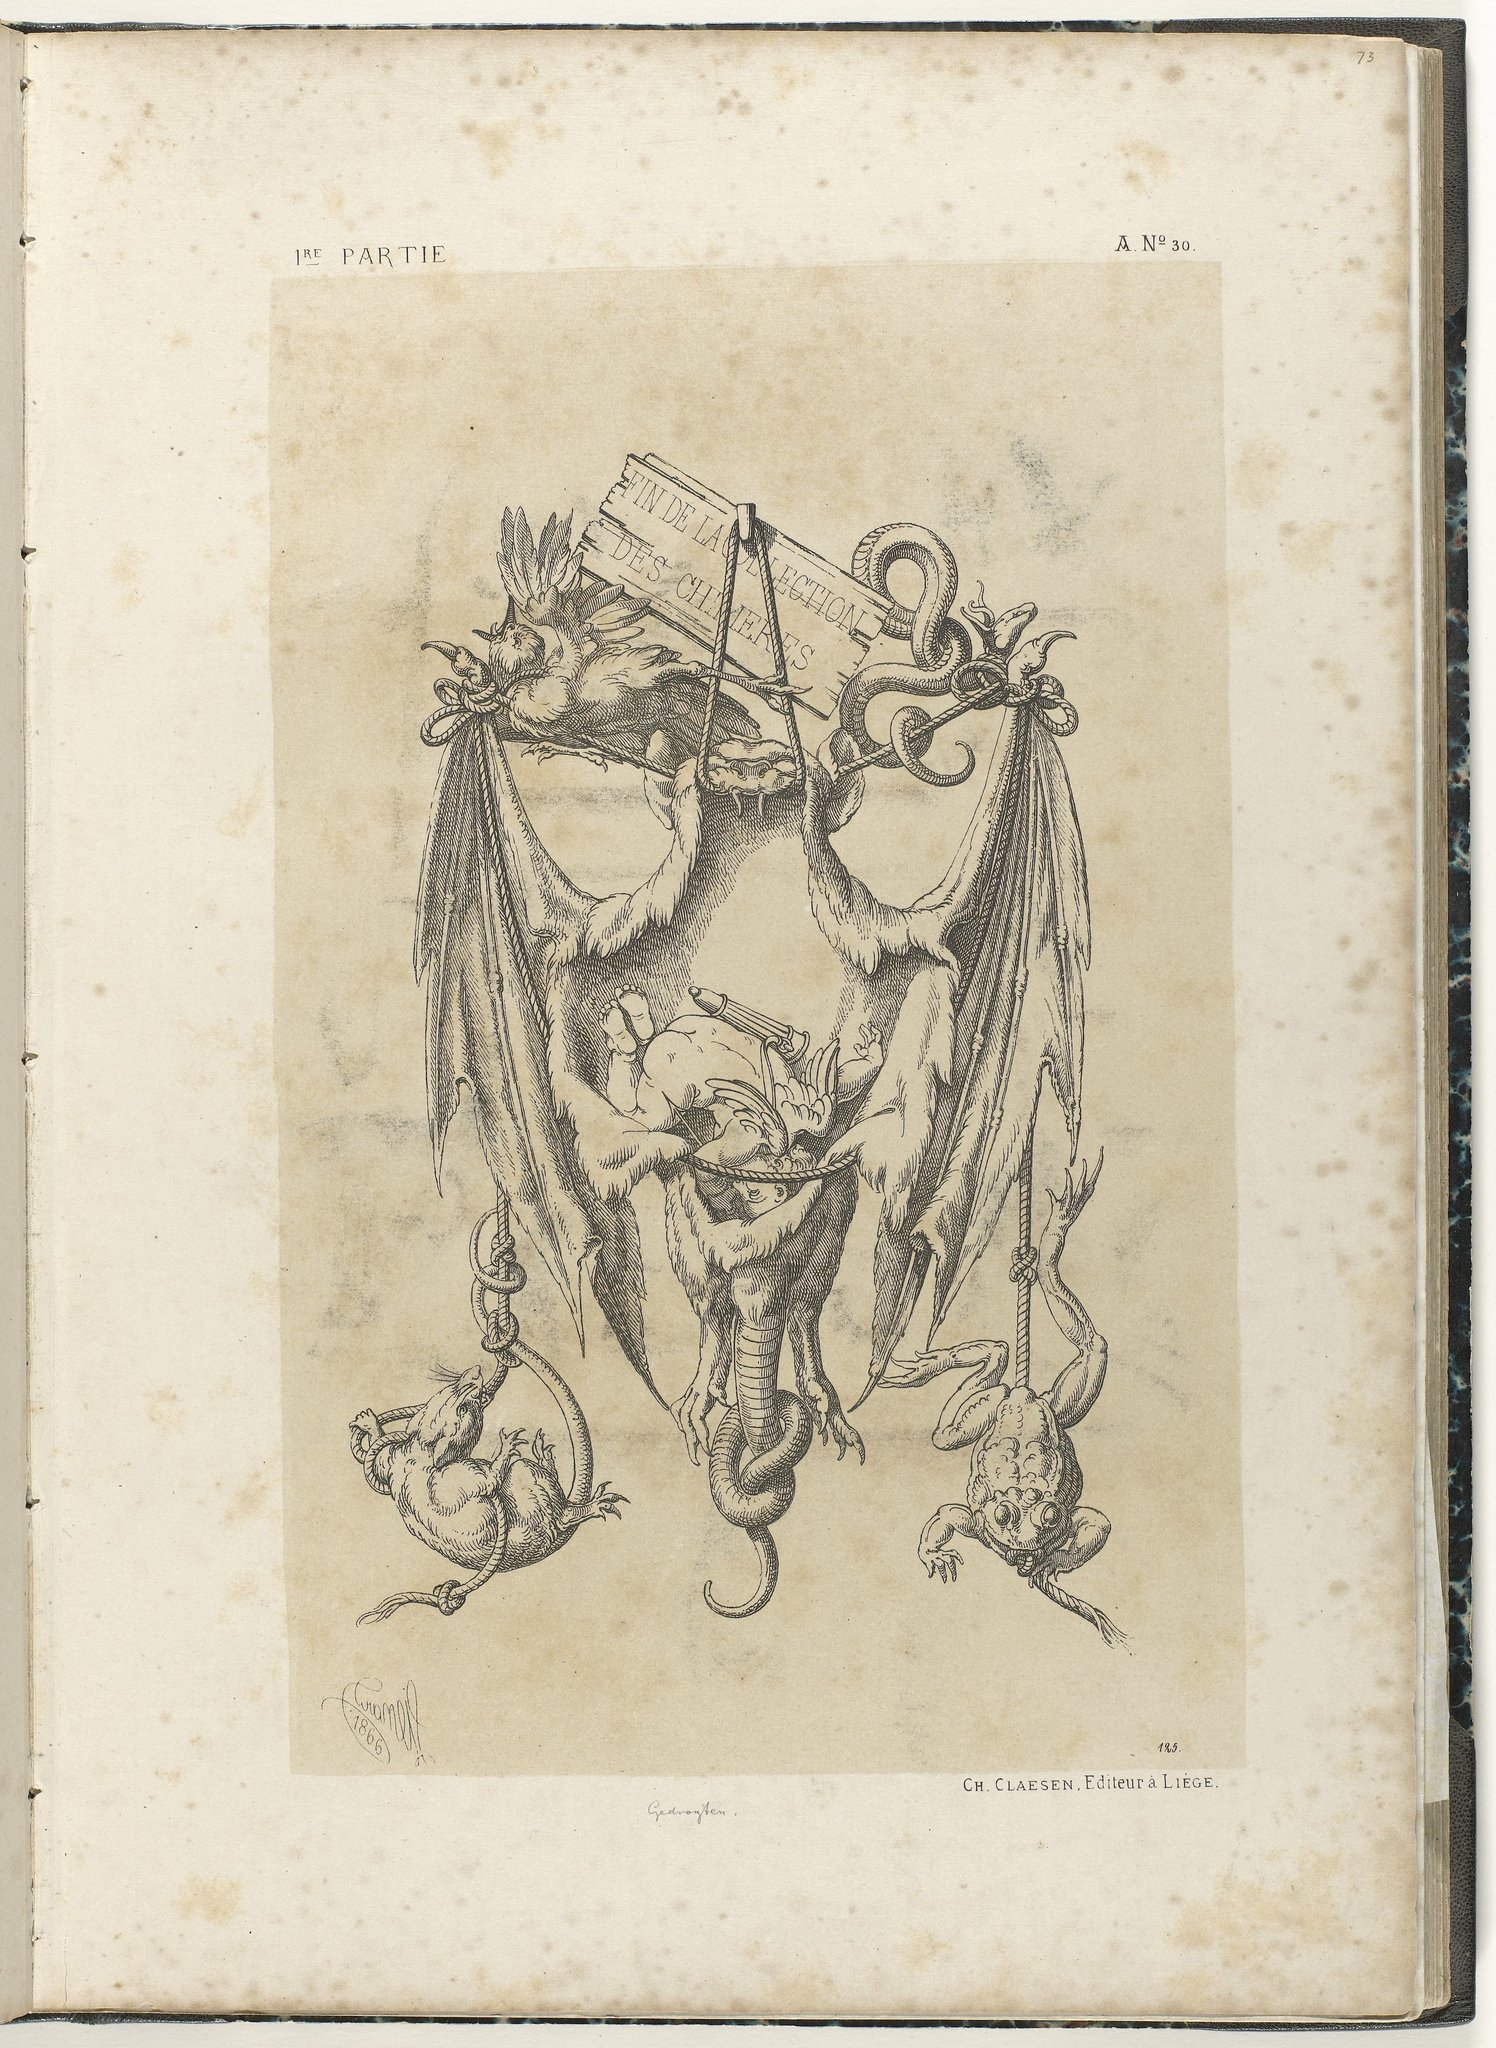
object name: print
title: Vleermuis met Amor in buikholte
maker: michel liénard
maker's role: print maker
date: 1866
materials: paper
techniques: tone lithography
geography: liège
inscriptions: annotation: ‘Gedrogten.’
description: Opengesneden vleermuis met knoop in zijn staart. De vleermuis hangt aan een touw waar ook een vogel, slang, rat en kikker aan vast zijn geknoopt. Linksboven staat: 1re partie, rechtsboven: A. N° 30., rechtsonder: 125.